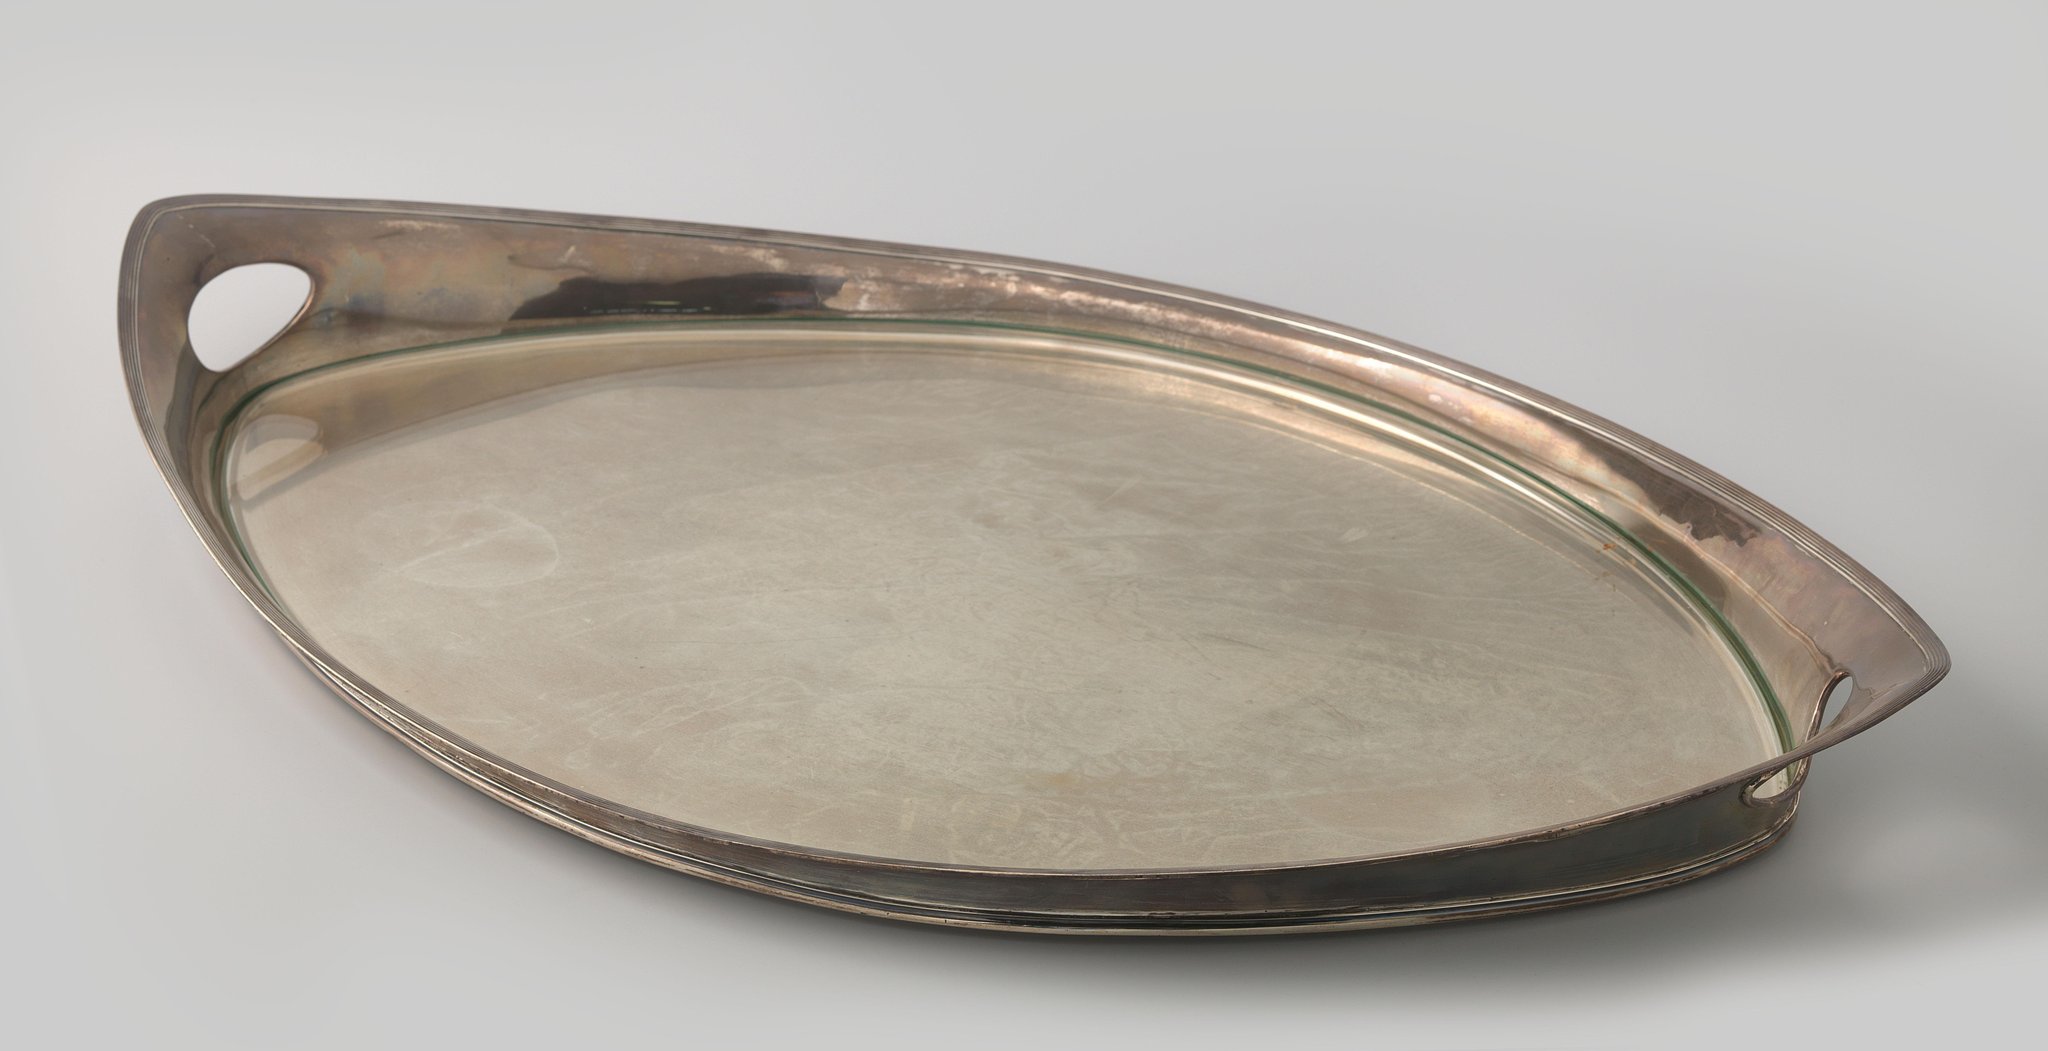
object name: blad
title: Dienblad van zilver, spitsovaal, met ovale handgrepen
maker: hendrik smits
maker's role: silversmith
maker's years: 1772-1841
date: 1820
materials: silver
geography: amsterdam